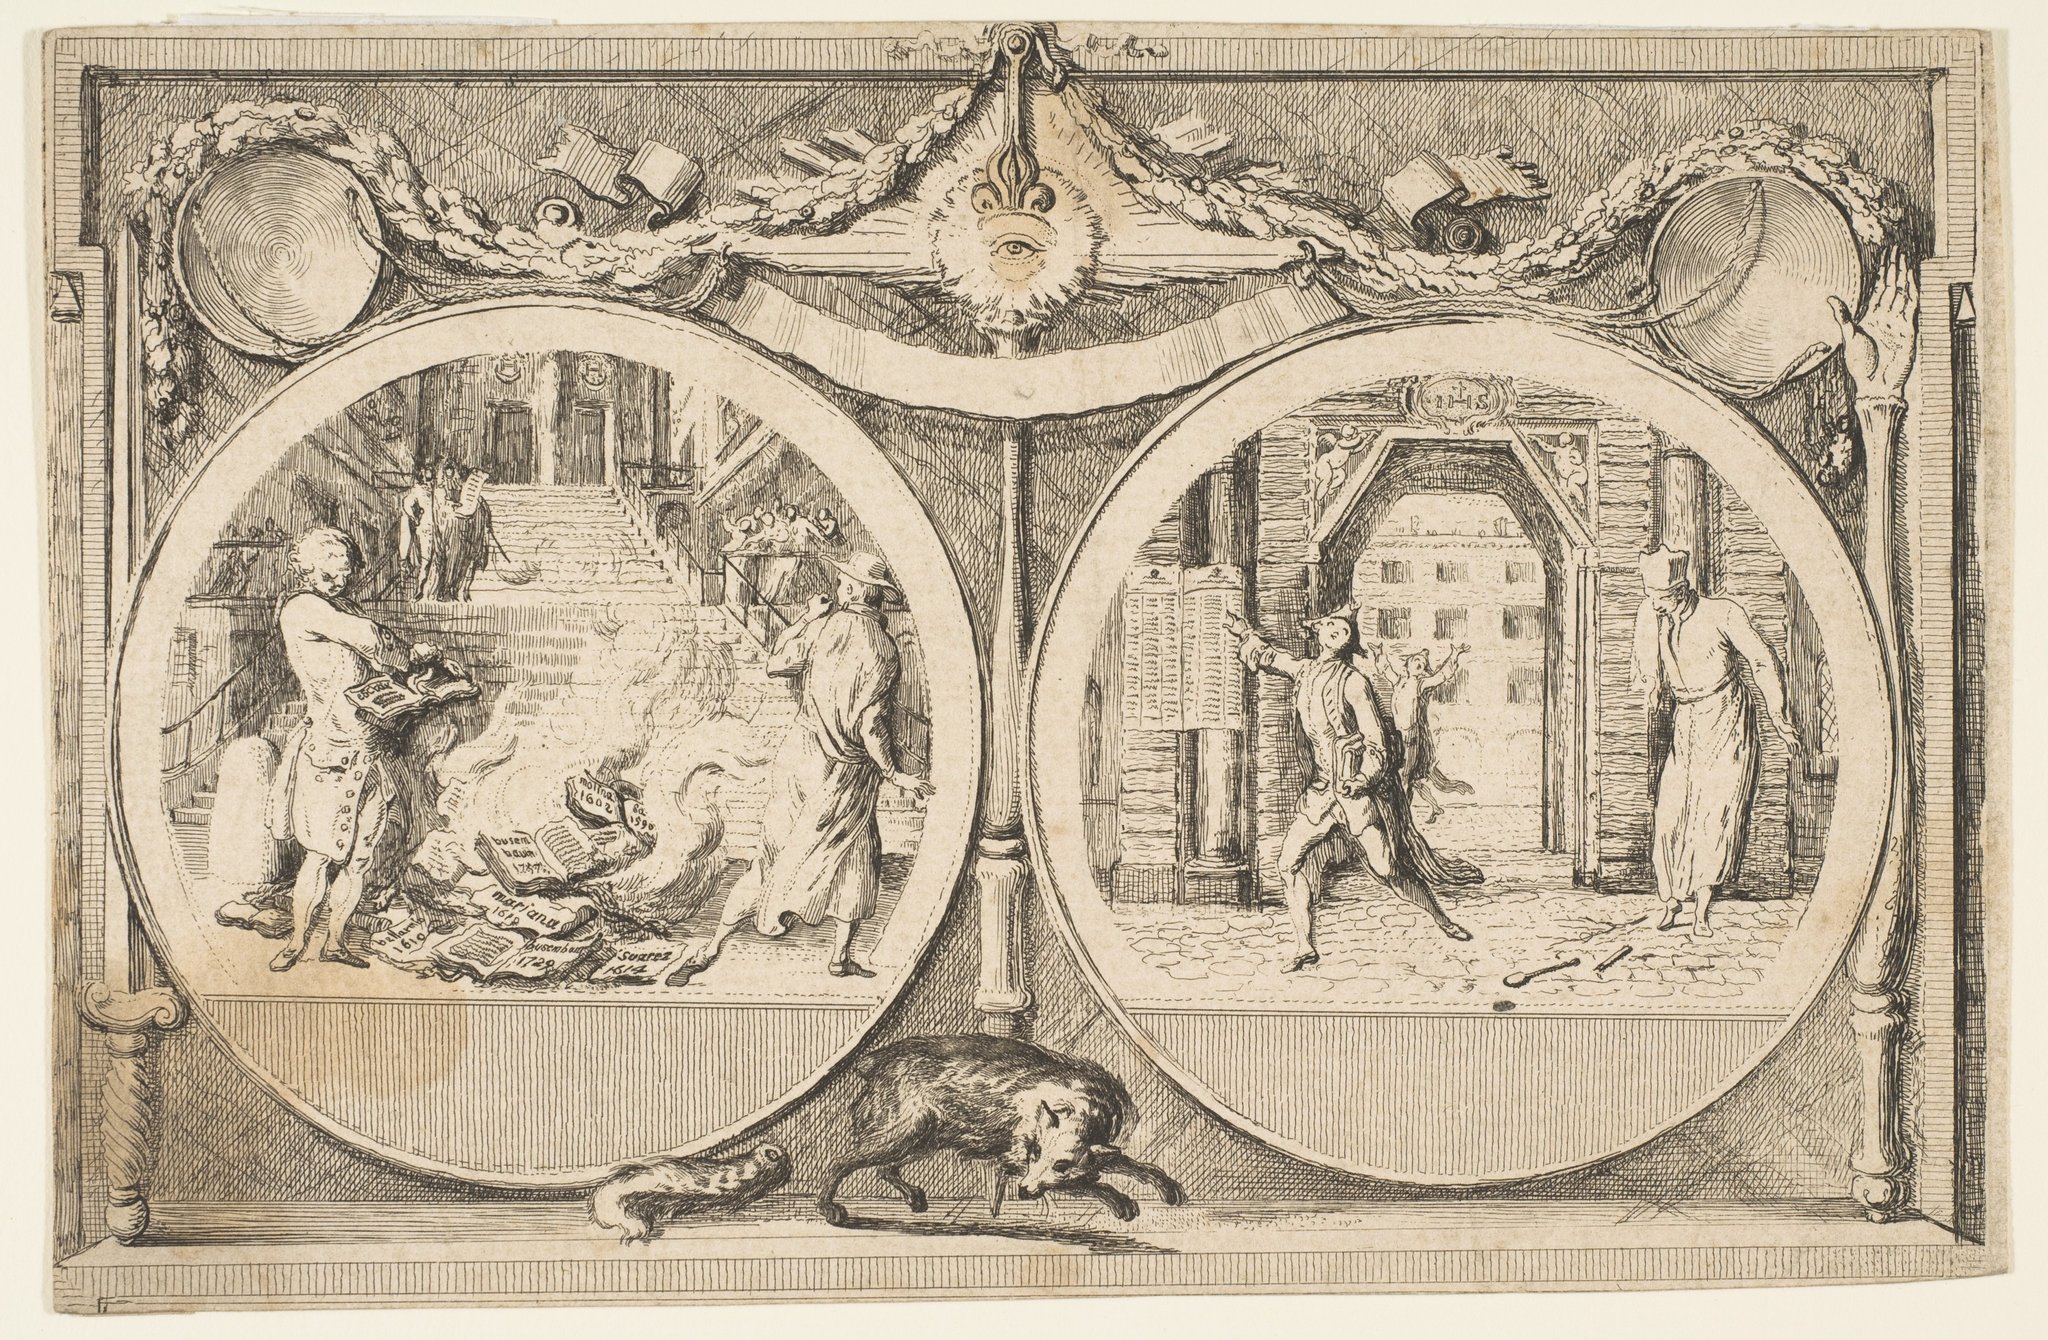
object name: print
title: The Expulsion of the Jesuits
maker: gabriel de saint-aubin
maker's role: artist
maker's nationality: french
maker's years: 1724-1780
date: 1761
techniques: etching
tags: animals,books,men,fire